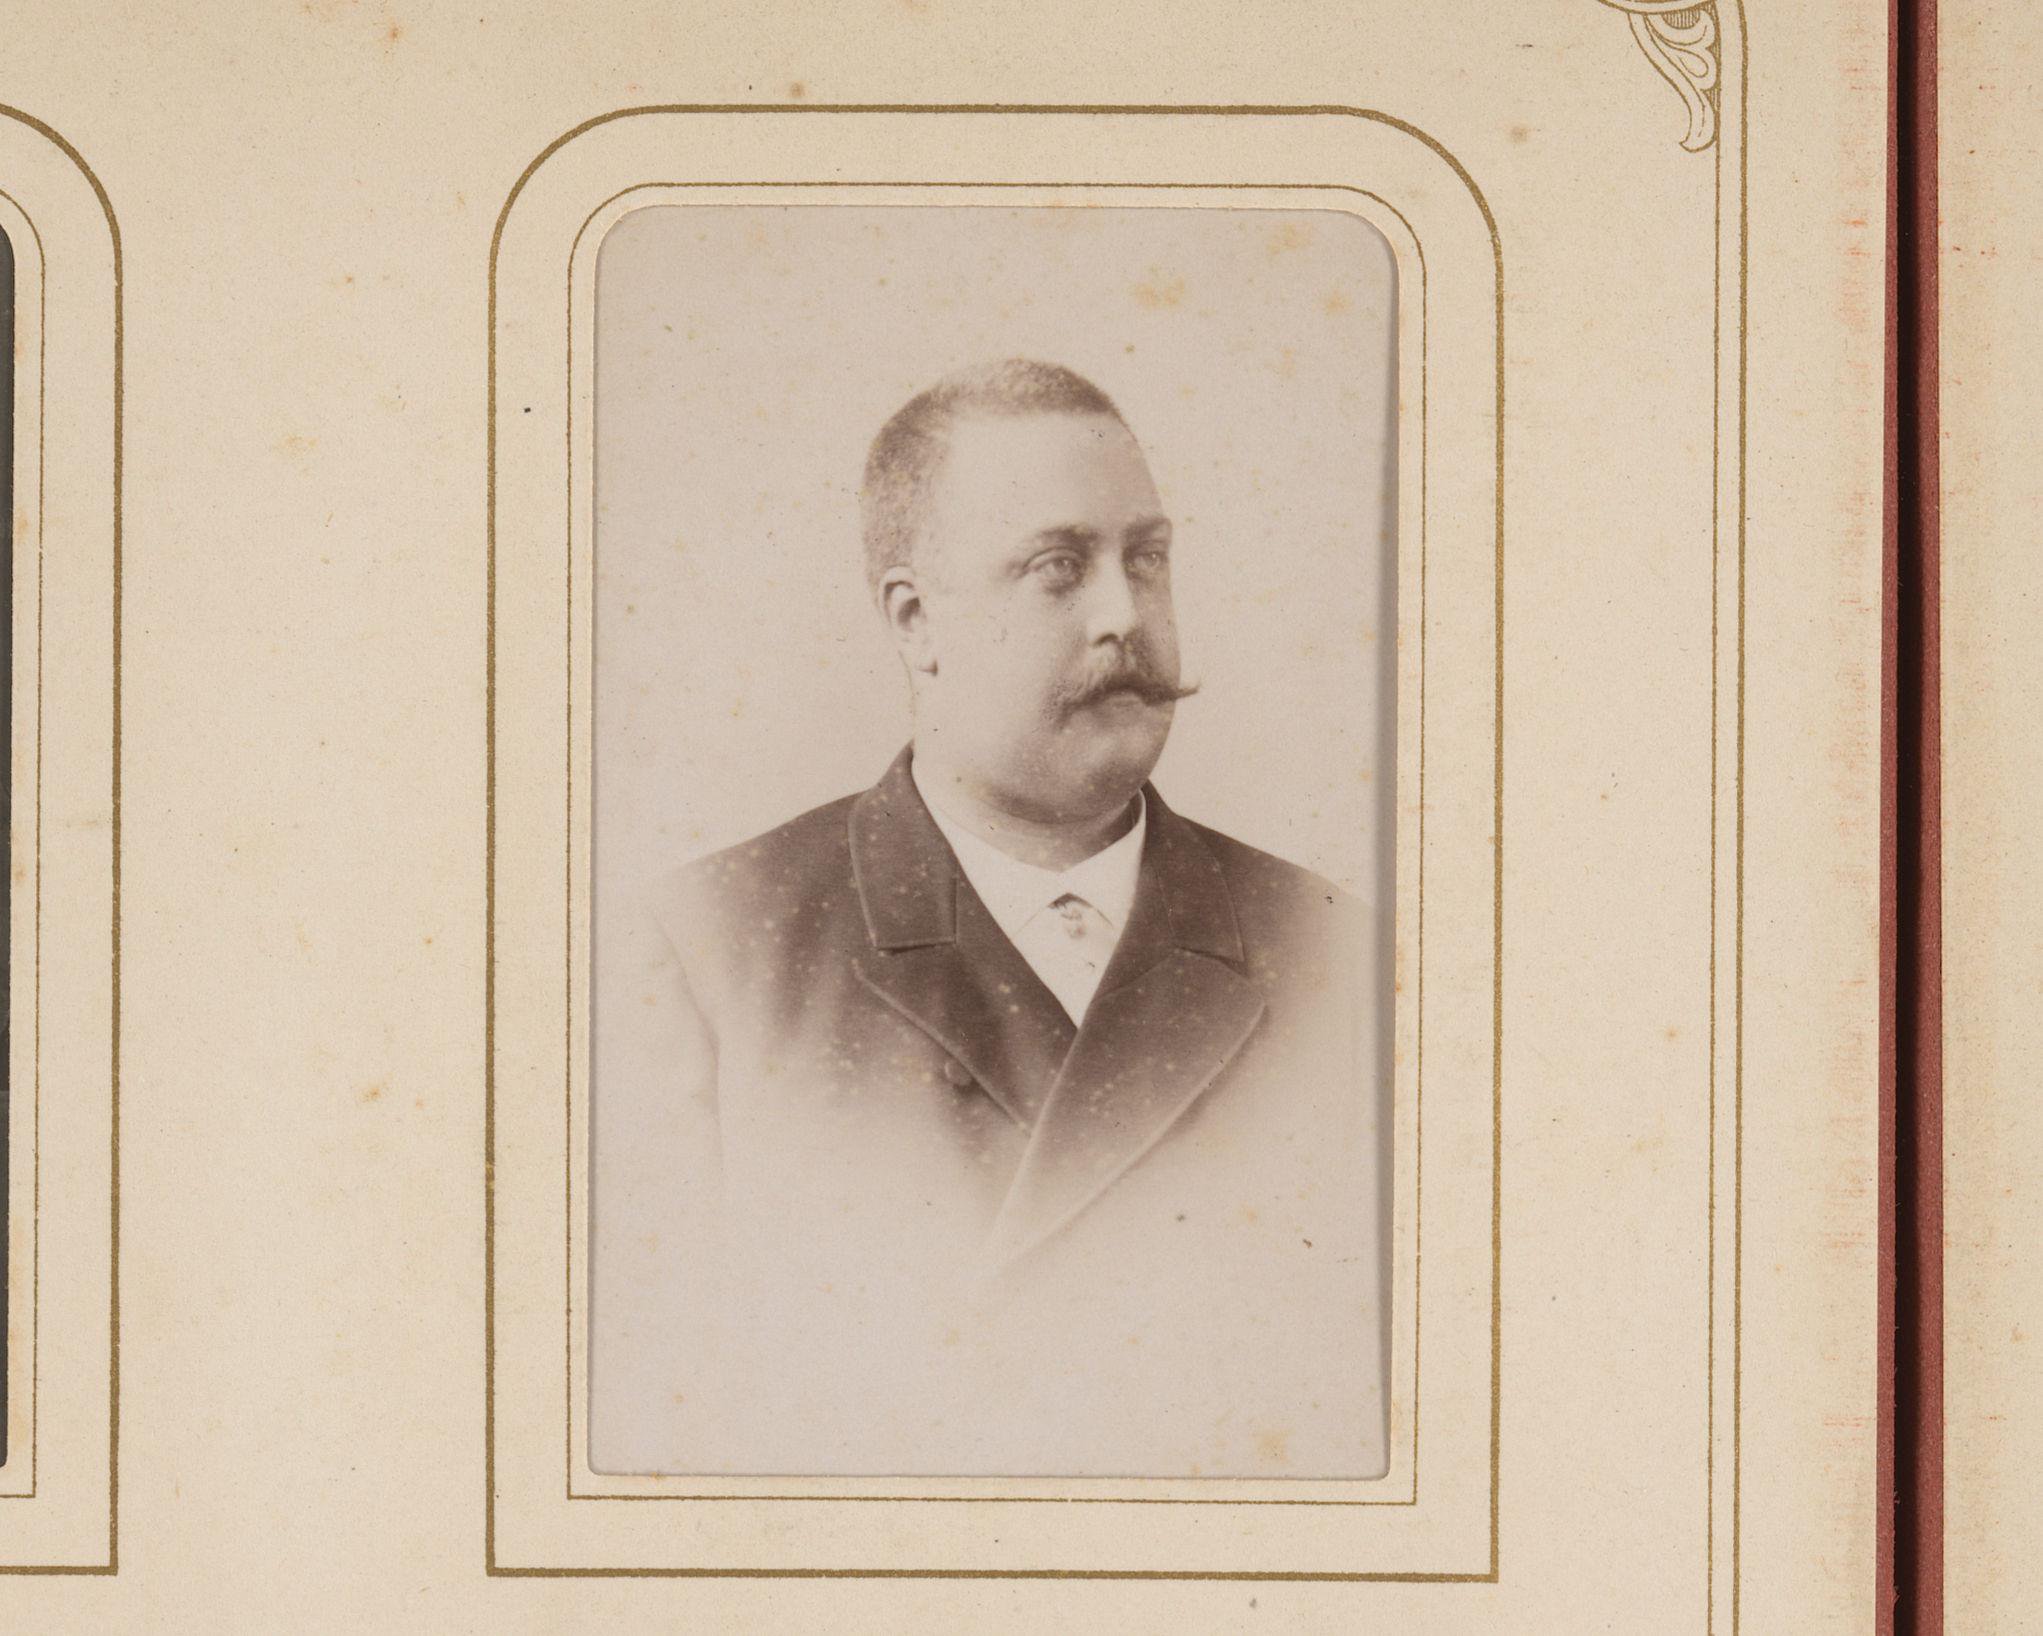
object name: album leaf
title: Portret van een man met snor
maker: max büttinghausen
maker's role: fotograaf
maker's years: 1847-1906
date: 1873-1886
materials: cardboard, photographic support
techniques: albumen print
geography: amsterdam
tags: moustache, historical persons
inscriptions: inscription: ‘M. Büttinghausen/ Photographisch artistisch Atelier./ Amsterdam/ Singel bij het Koningsplein No. 512./ SPECIALITEIT IN VERGROOTINGEN.’